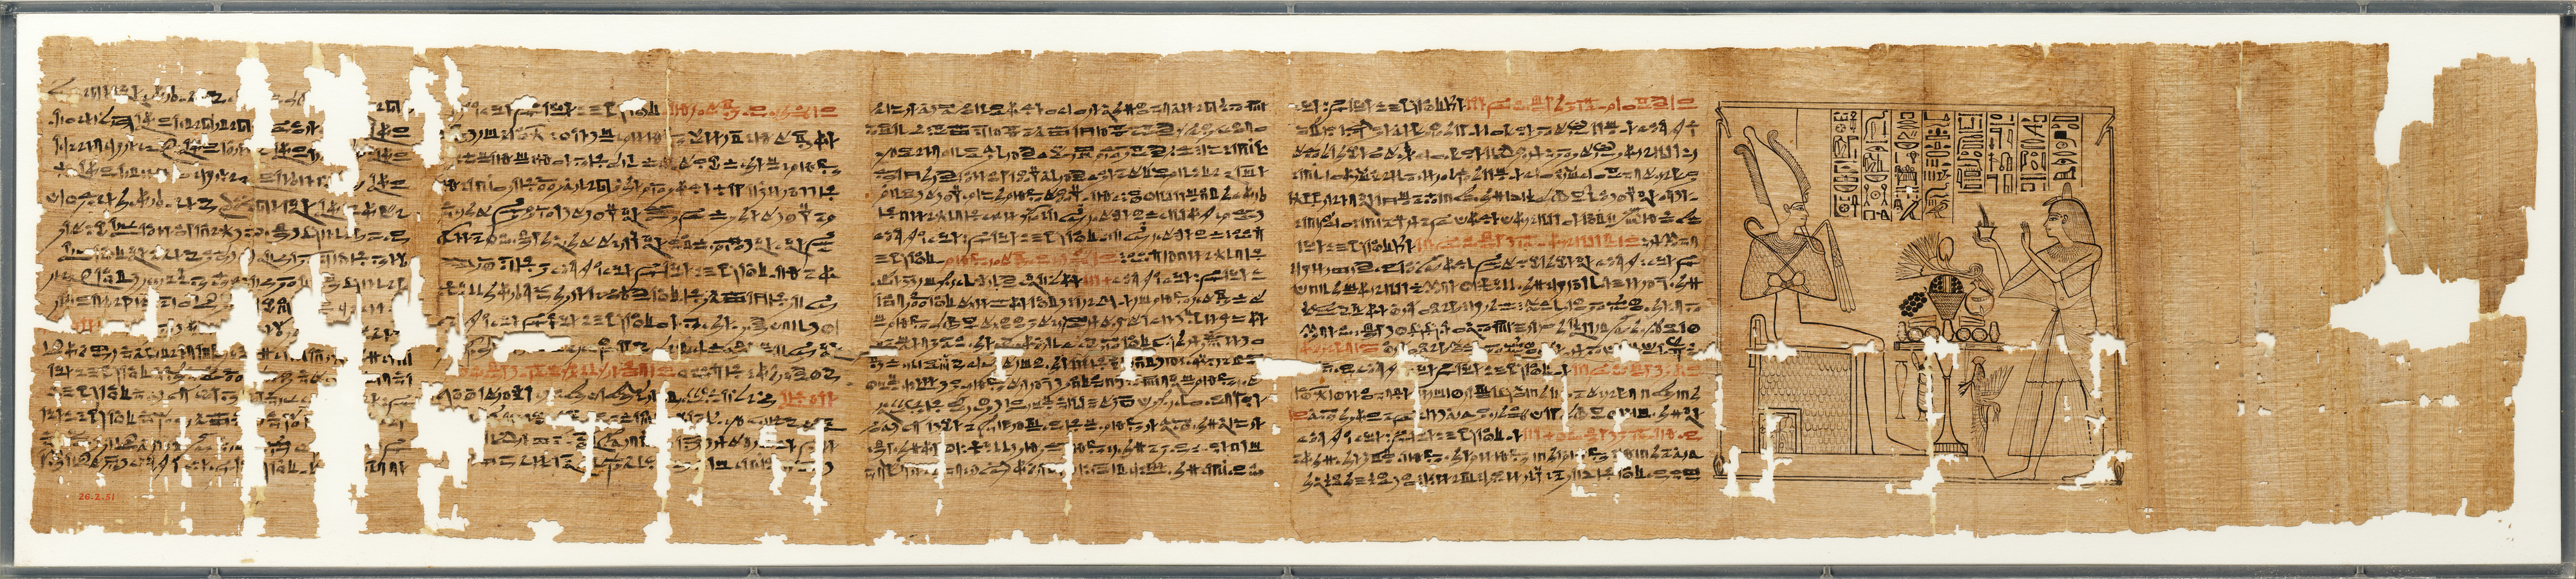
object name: papyrus, funerary, book of the dead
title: Nesiamun's Book of the Dead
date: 1070-945 BCE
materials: ink, papyrus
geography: upper egypt, thebes